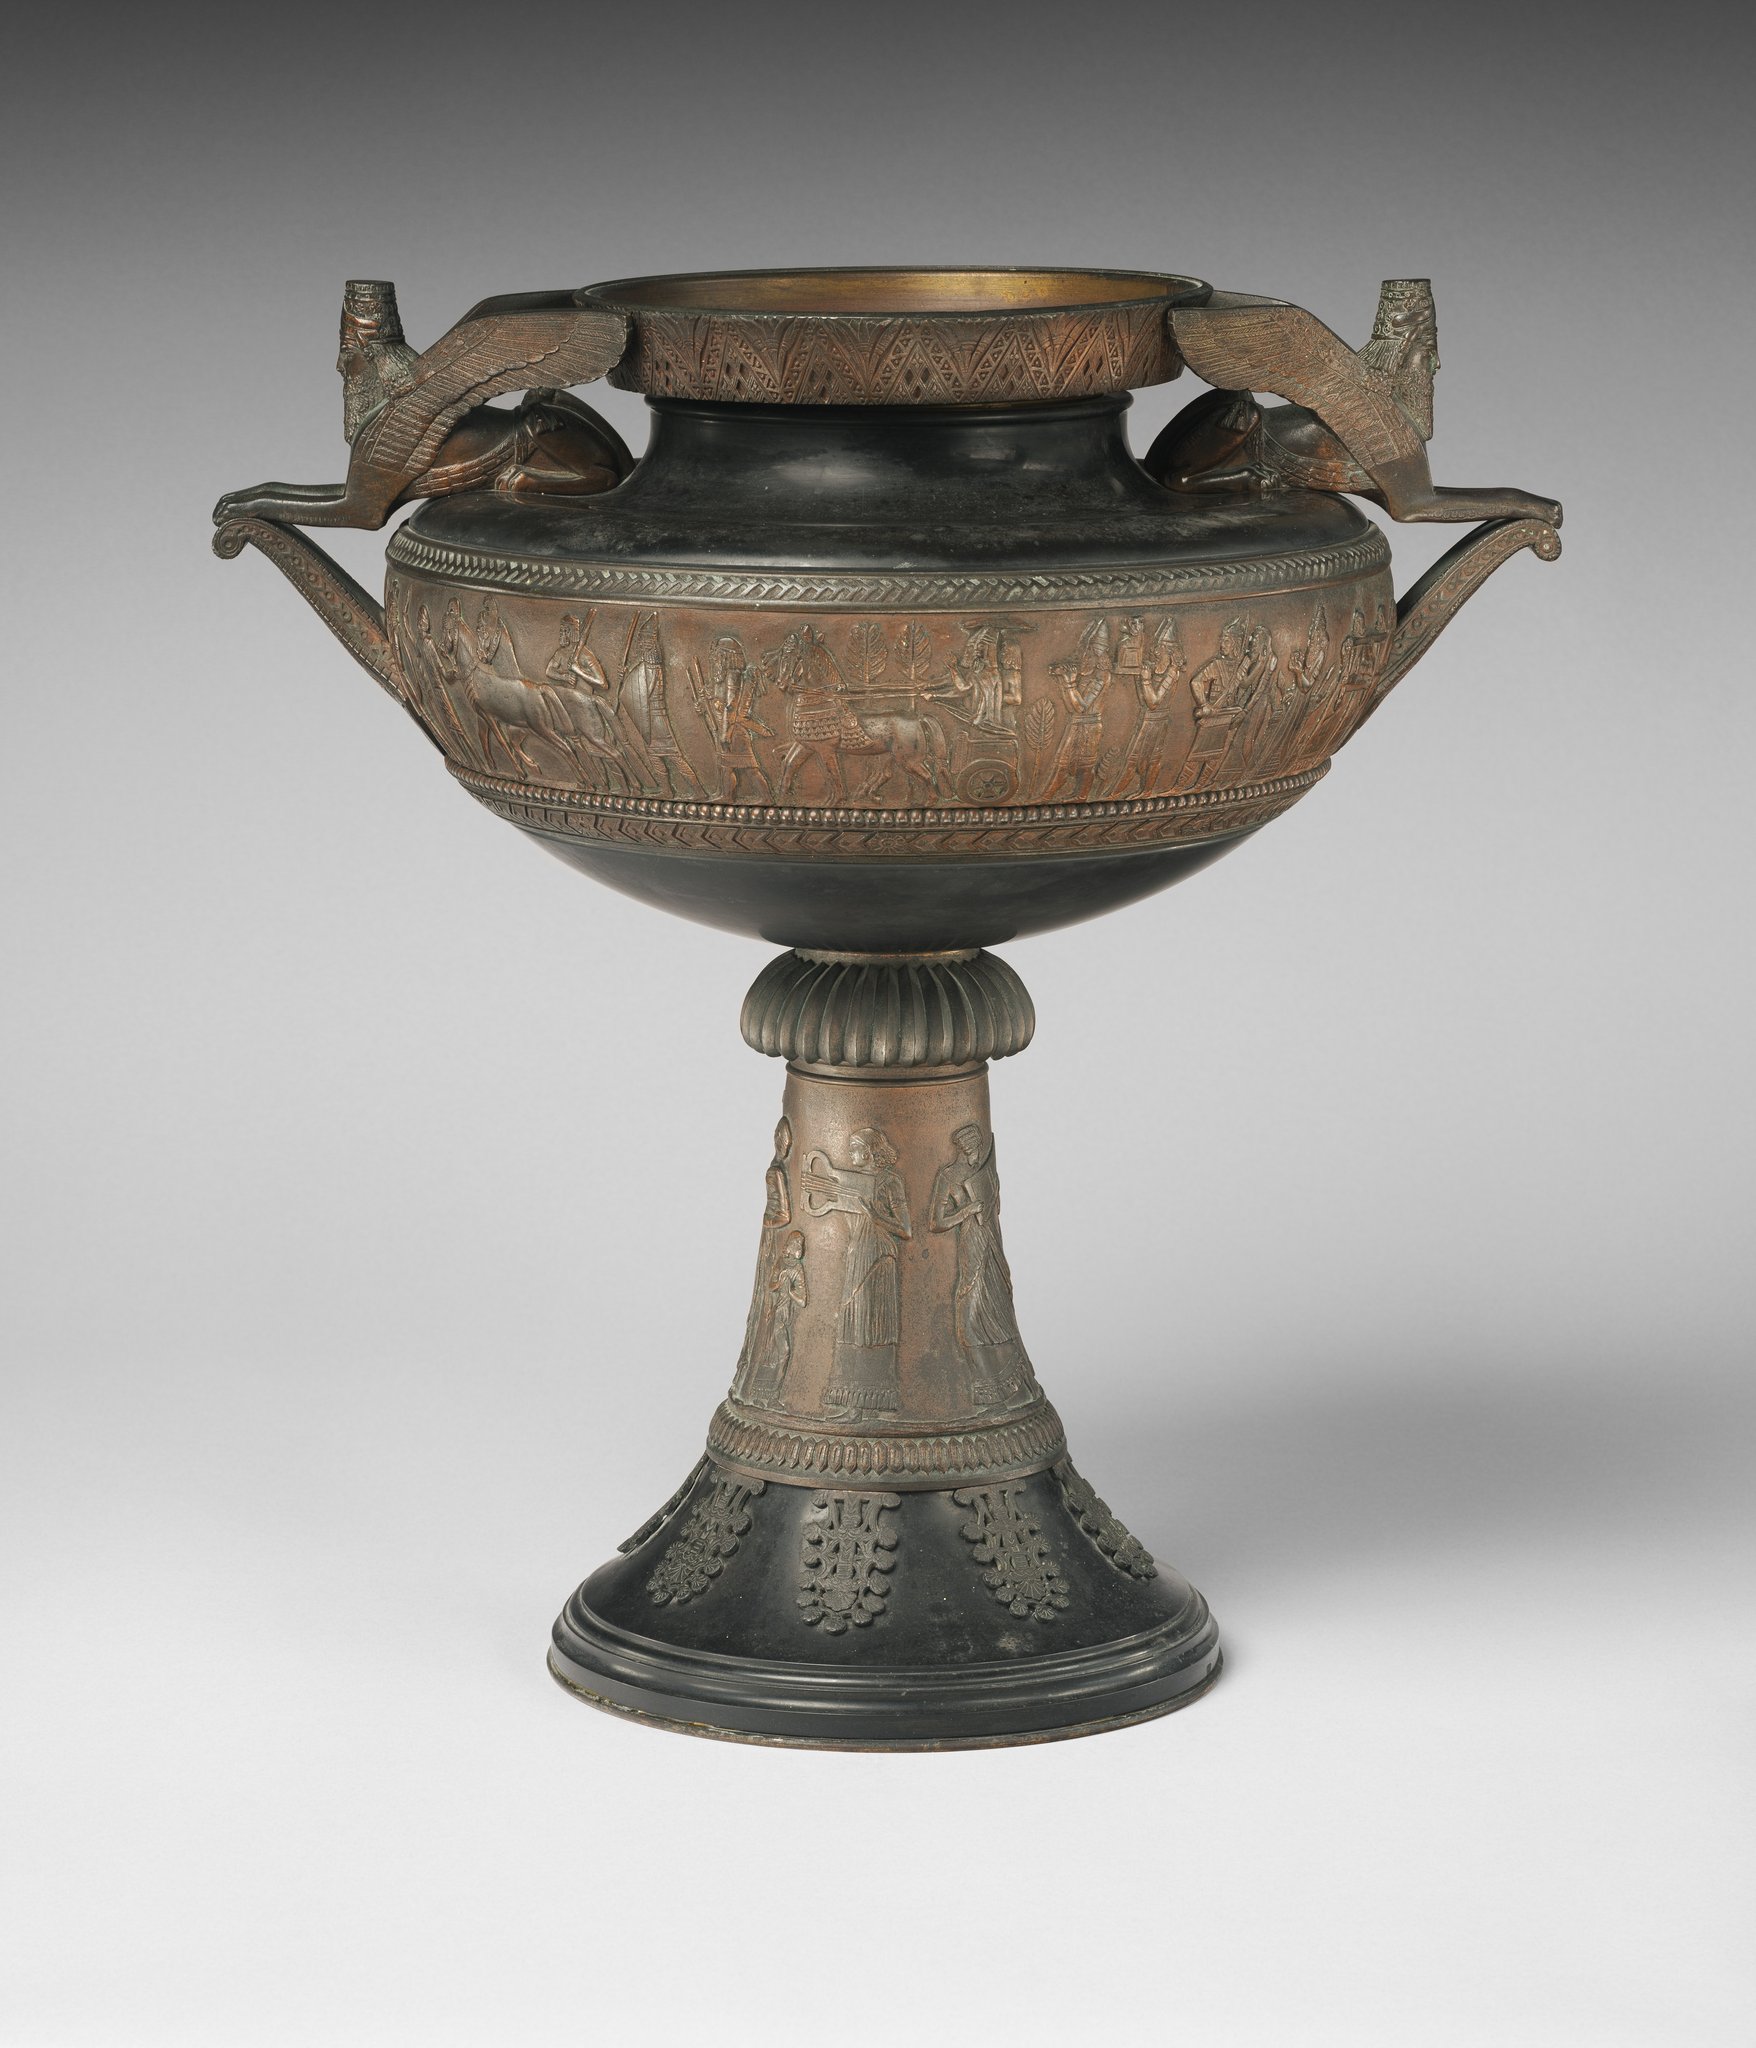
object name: urn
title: Urn with Assyrian scenes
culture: french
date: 1851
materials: bronze